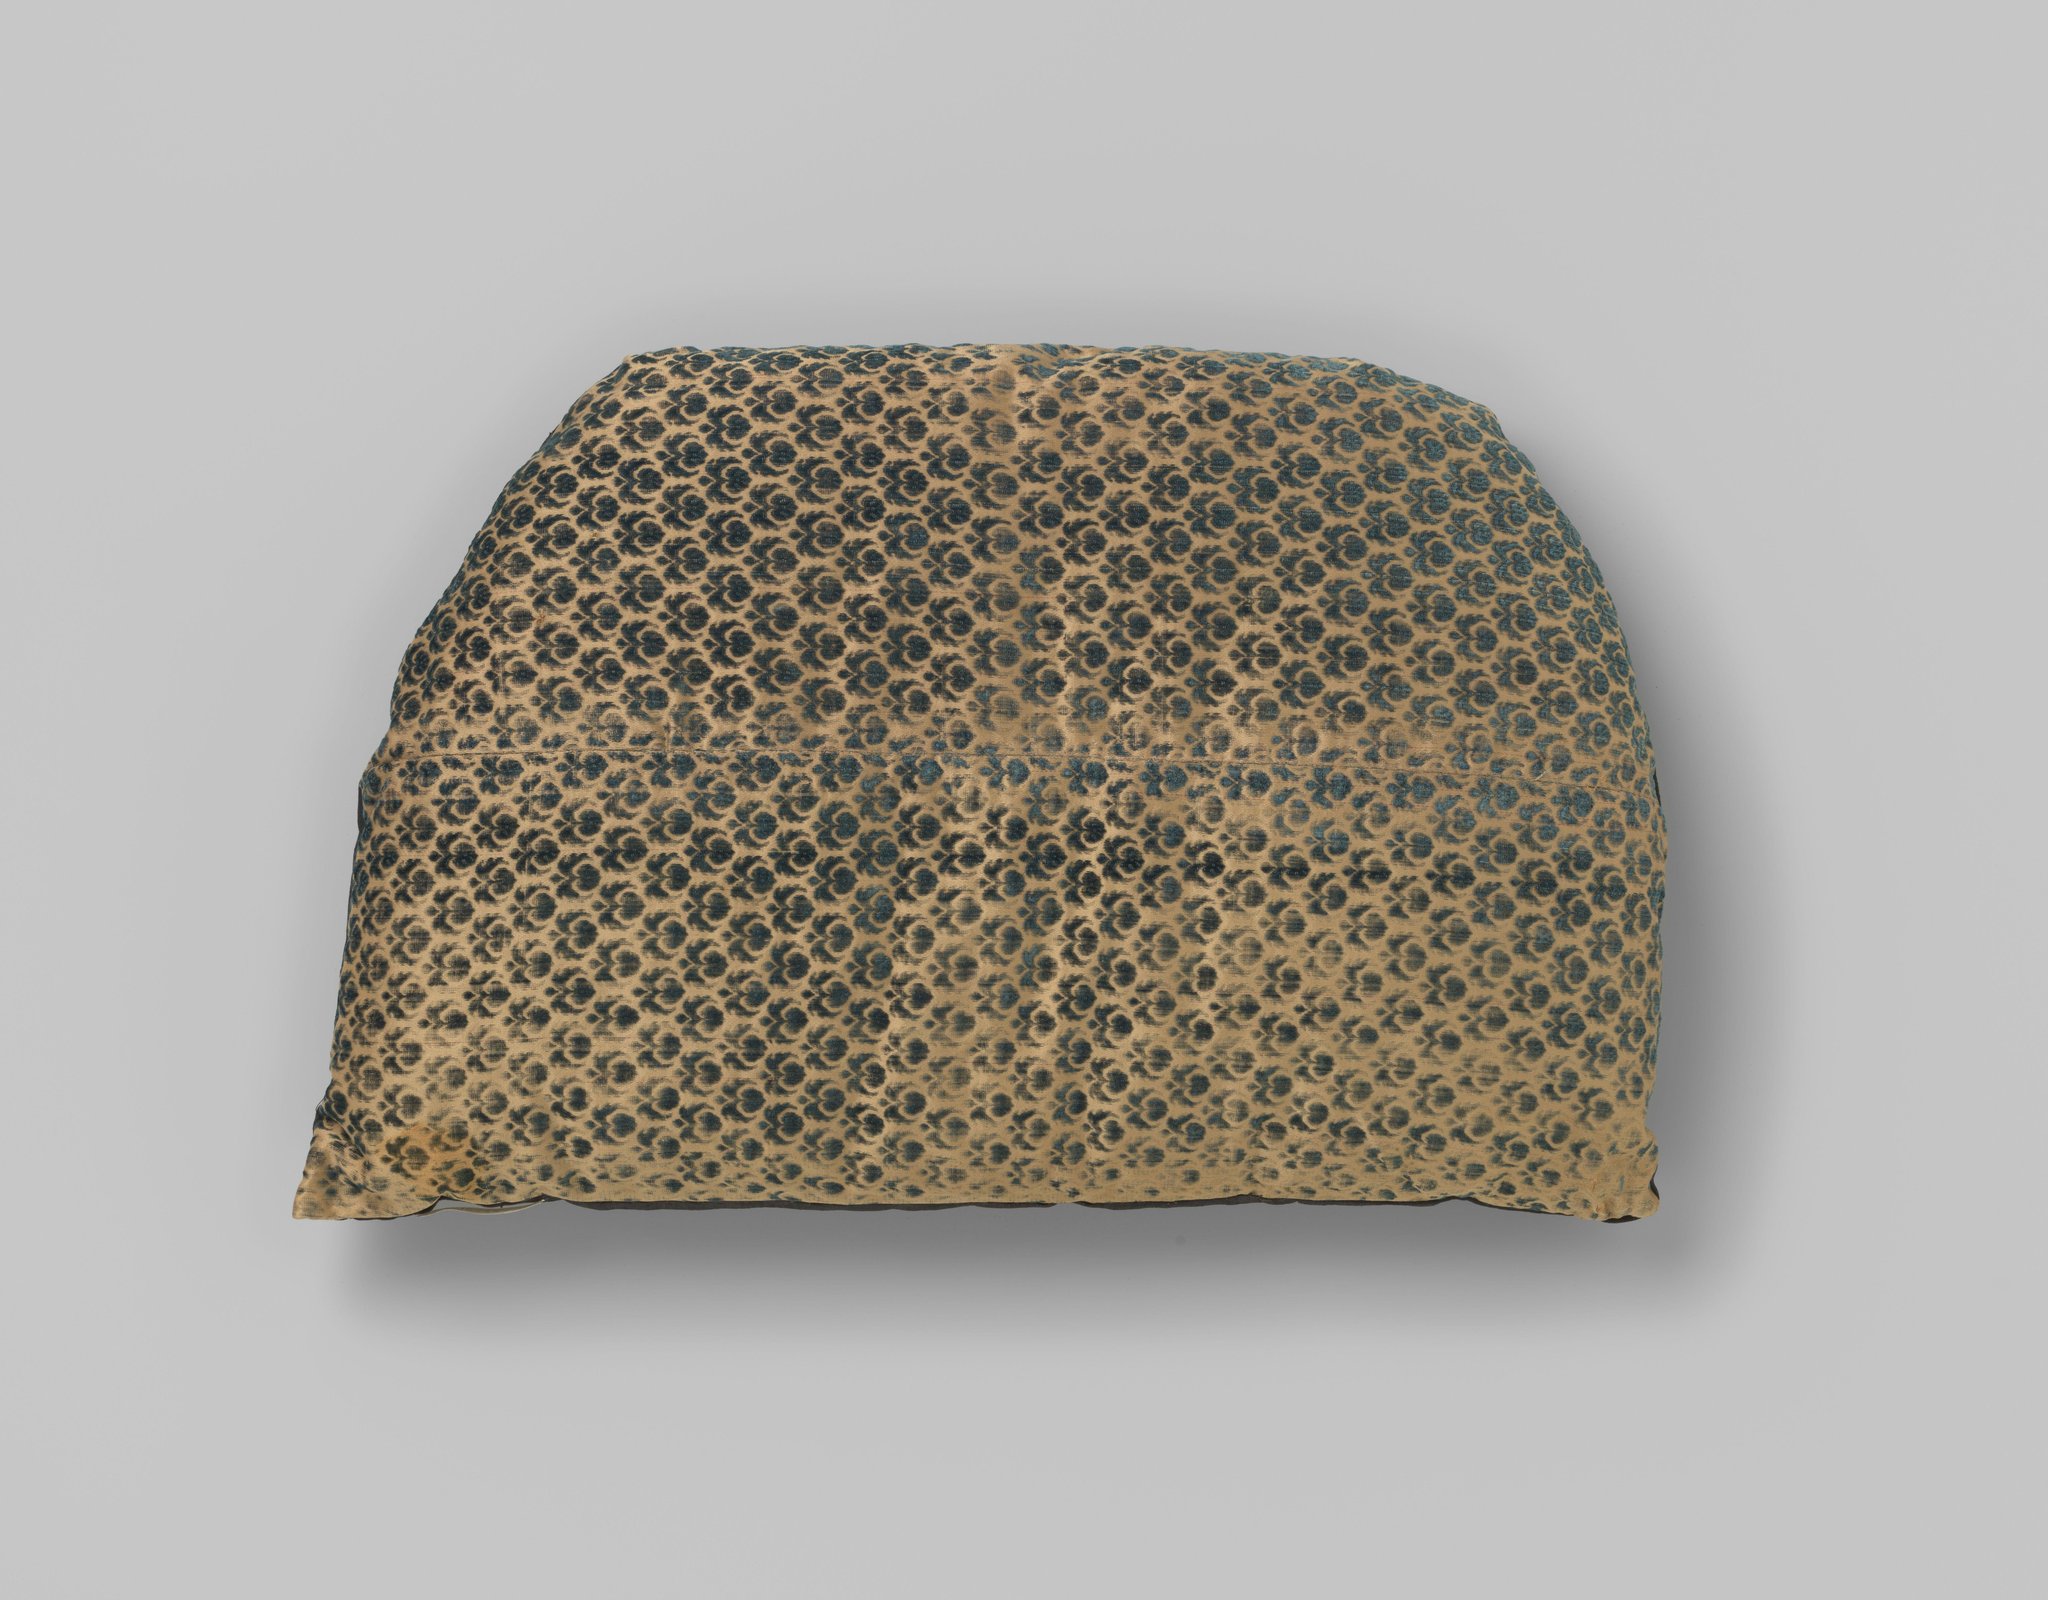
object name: mat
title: Kleedje versierd met strooipatroon van blauwe palmetten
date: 1575-1600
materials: gold, linen, textile, silk, velvet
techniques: cut velvet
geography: italy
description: Kussen van zijdefluweel bestaande uit twee samengenaaide fragmenten met een strooipatroon van blauwe palmetten op een beige satijnen grond. Het kussen is halfrond van vorm. De achterzijde is een grove zwarte geglansde linnen. Zijdefluweel identiek aan de zijdefluweel BK-15367.